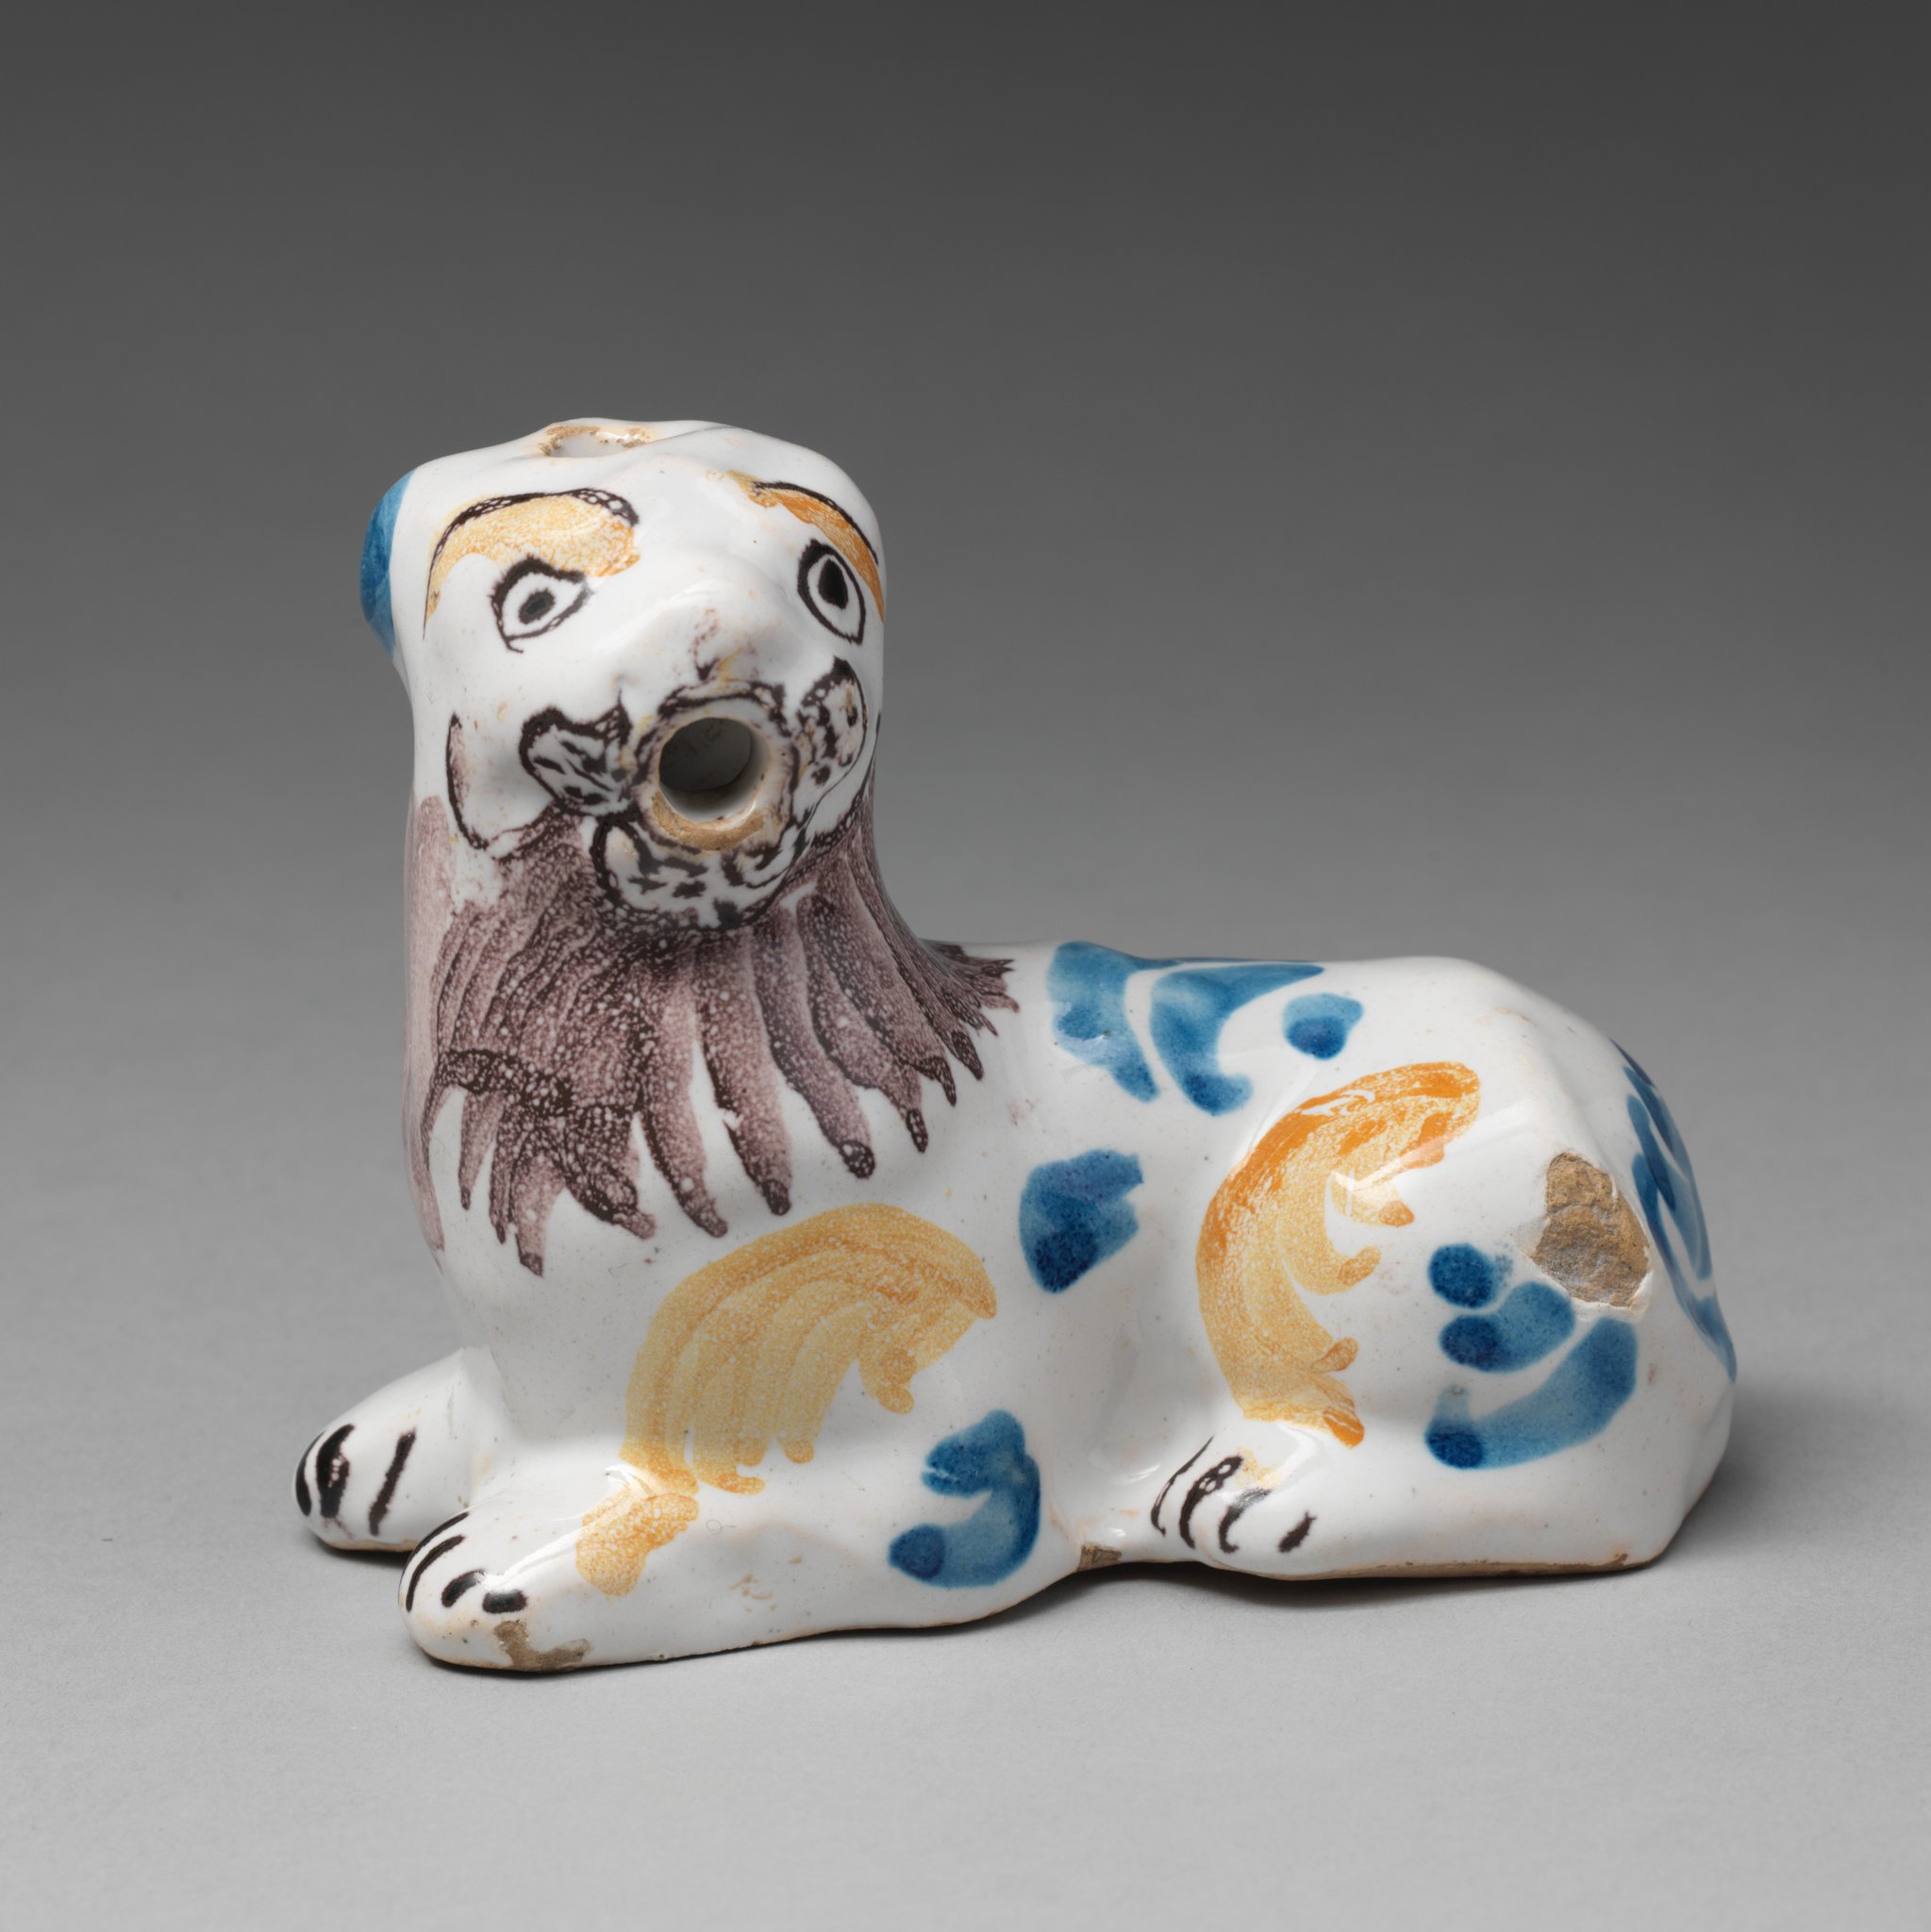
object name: figure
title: Lion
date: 1601-1633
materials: earthenware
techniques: glazing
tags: lions